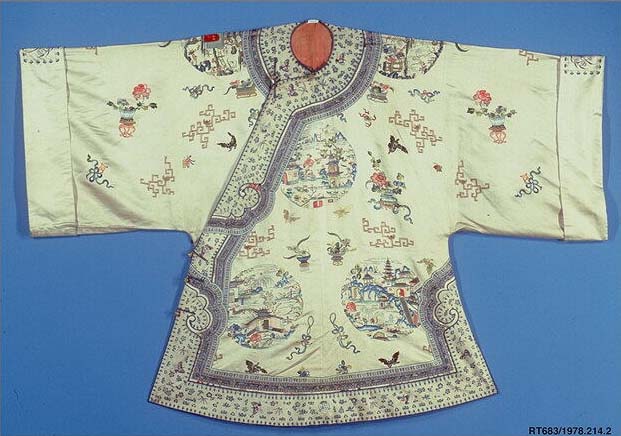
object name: woman's informal robe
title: Woman's Short Informal Robe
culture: chinese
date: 1900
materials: metal thread, silk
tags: birds